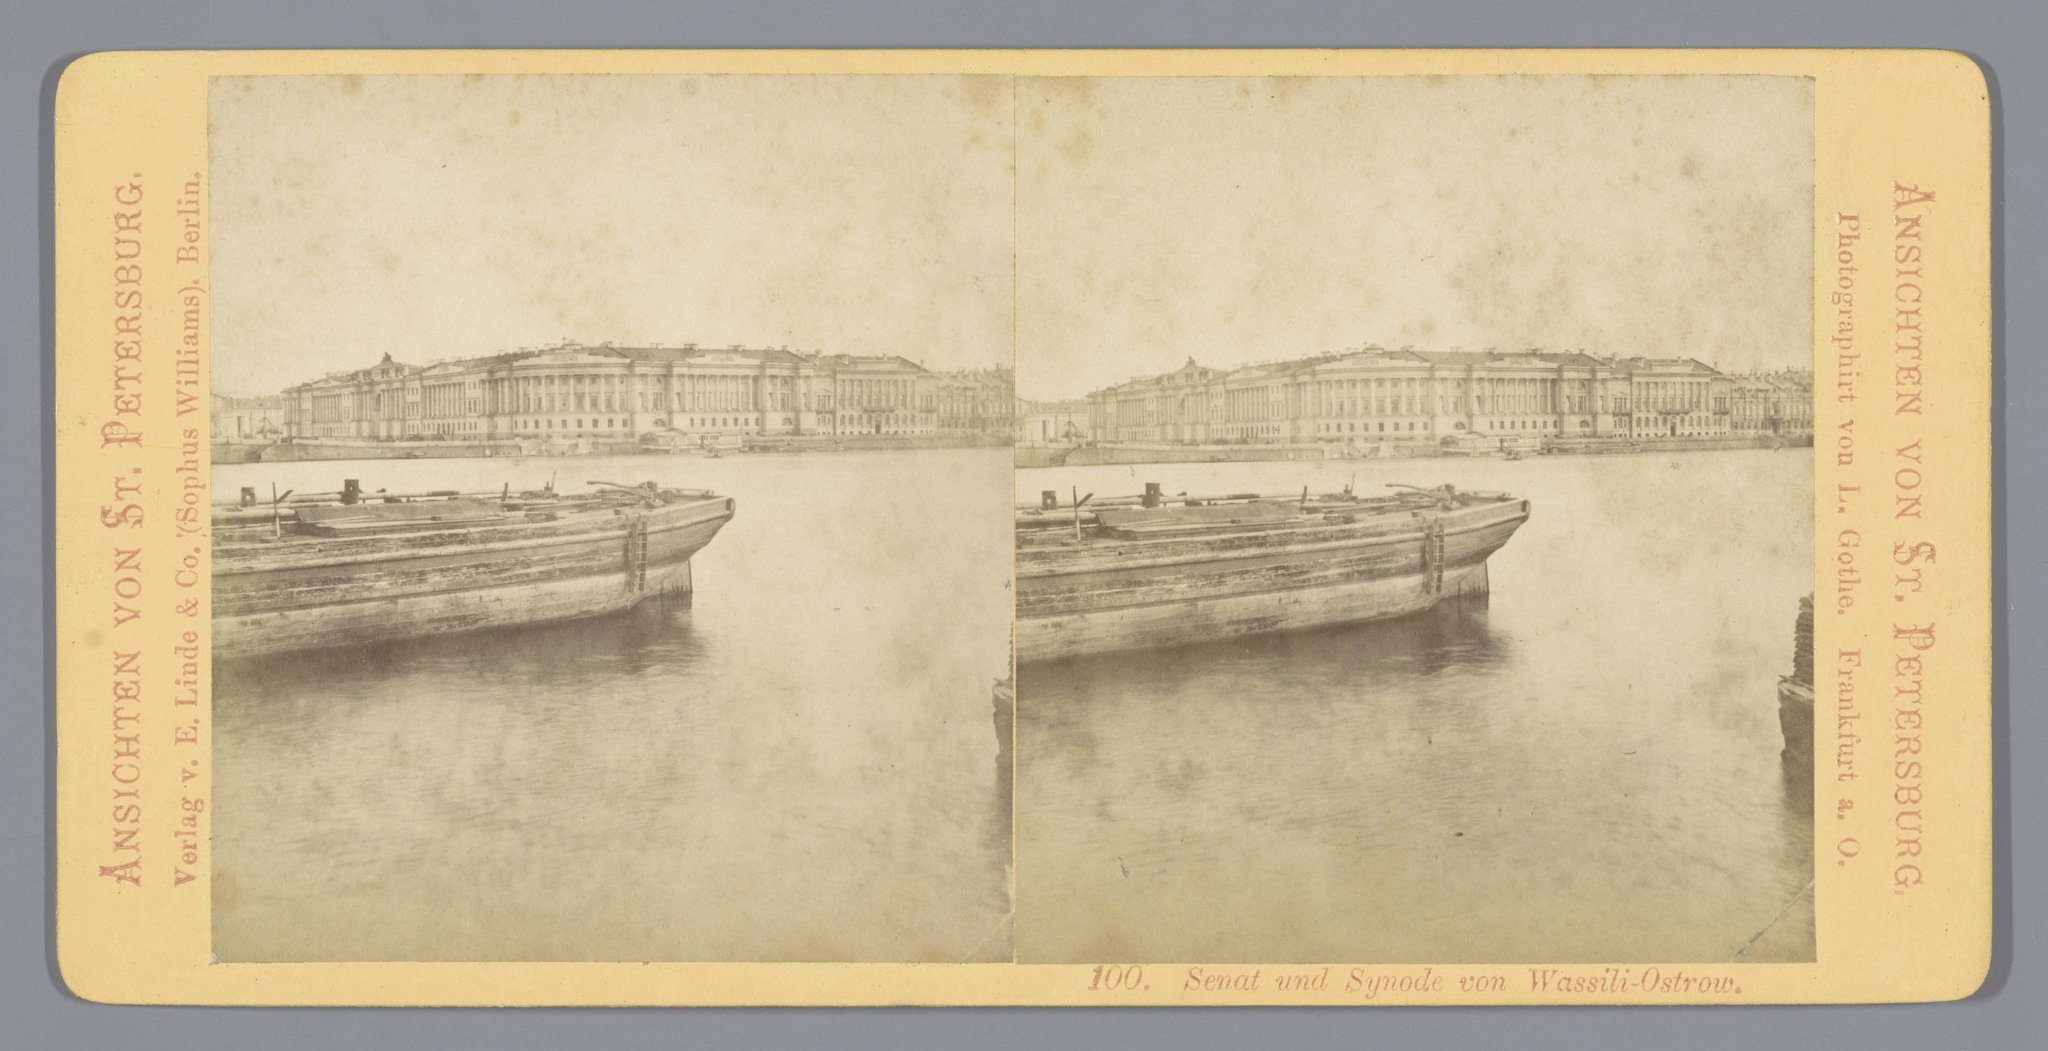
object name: stereograph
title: Senat und Synode von Wassili-Ostrow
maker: louis gothe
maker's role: fotograaf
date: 1850-1880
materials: cardboard, photographic support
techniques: albumen print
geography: sint-petersburg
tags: river, council, synod ~ roman catholic church, upper house, senate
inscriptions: number: ‘100.’, inscription: ‘Ansichten von St. Petersburg.’